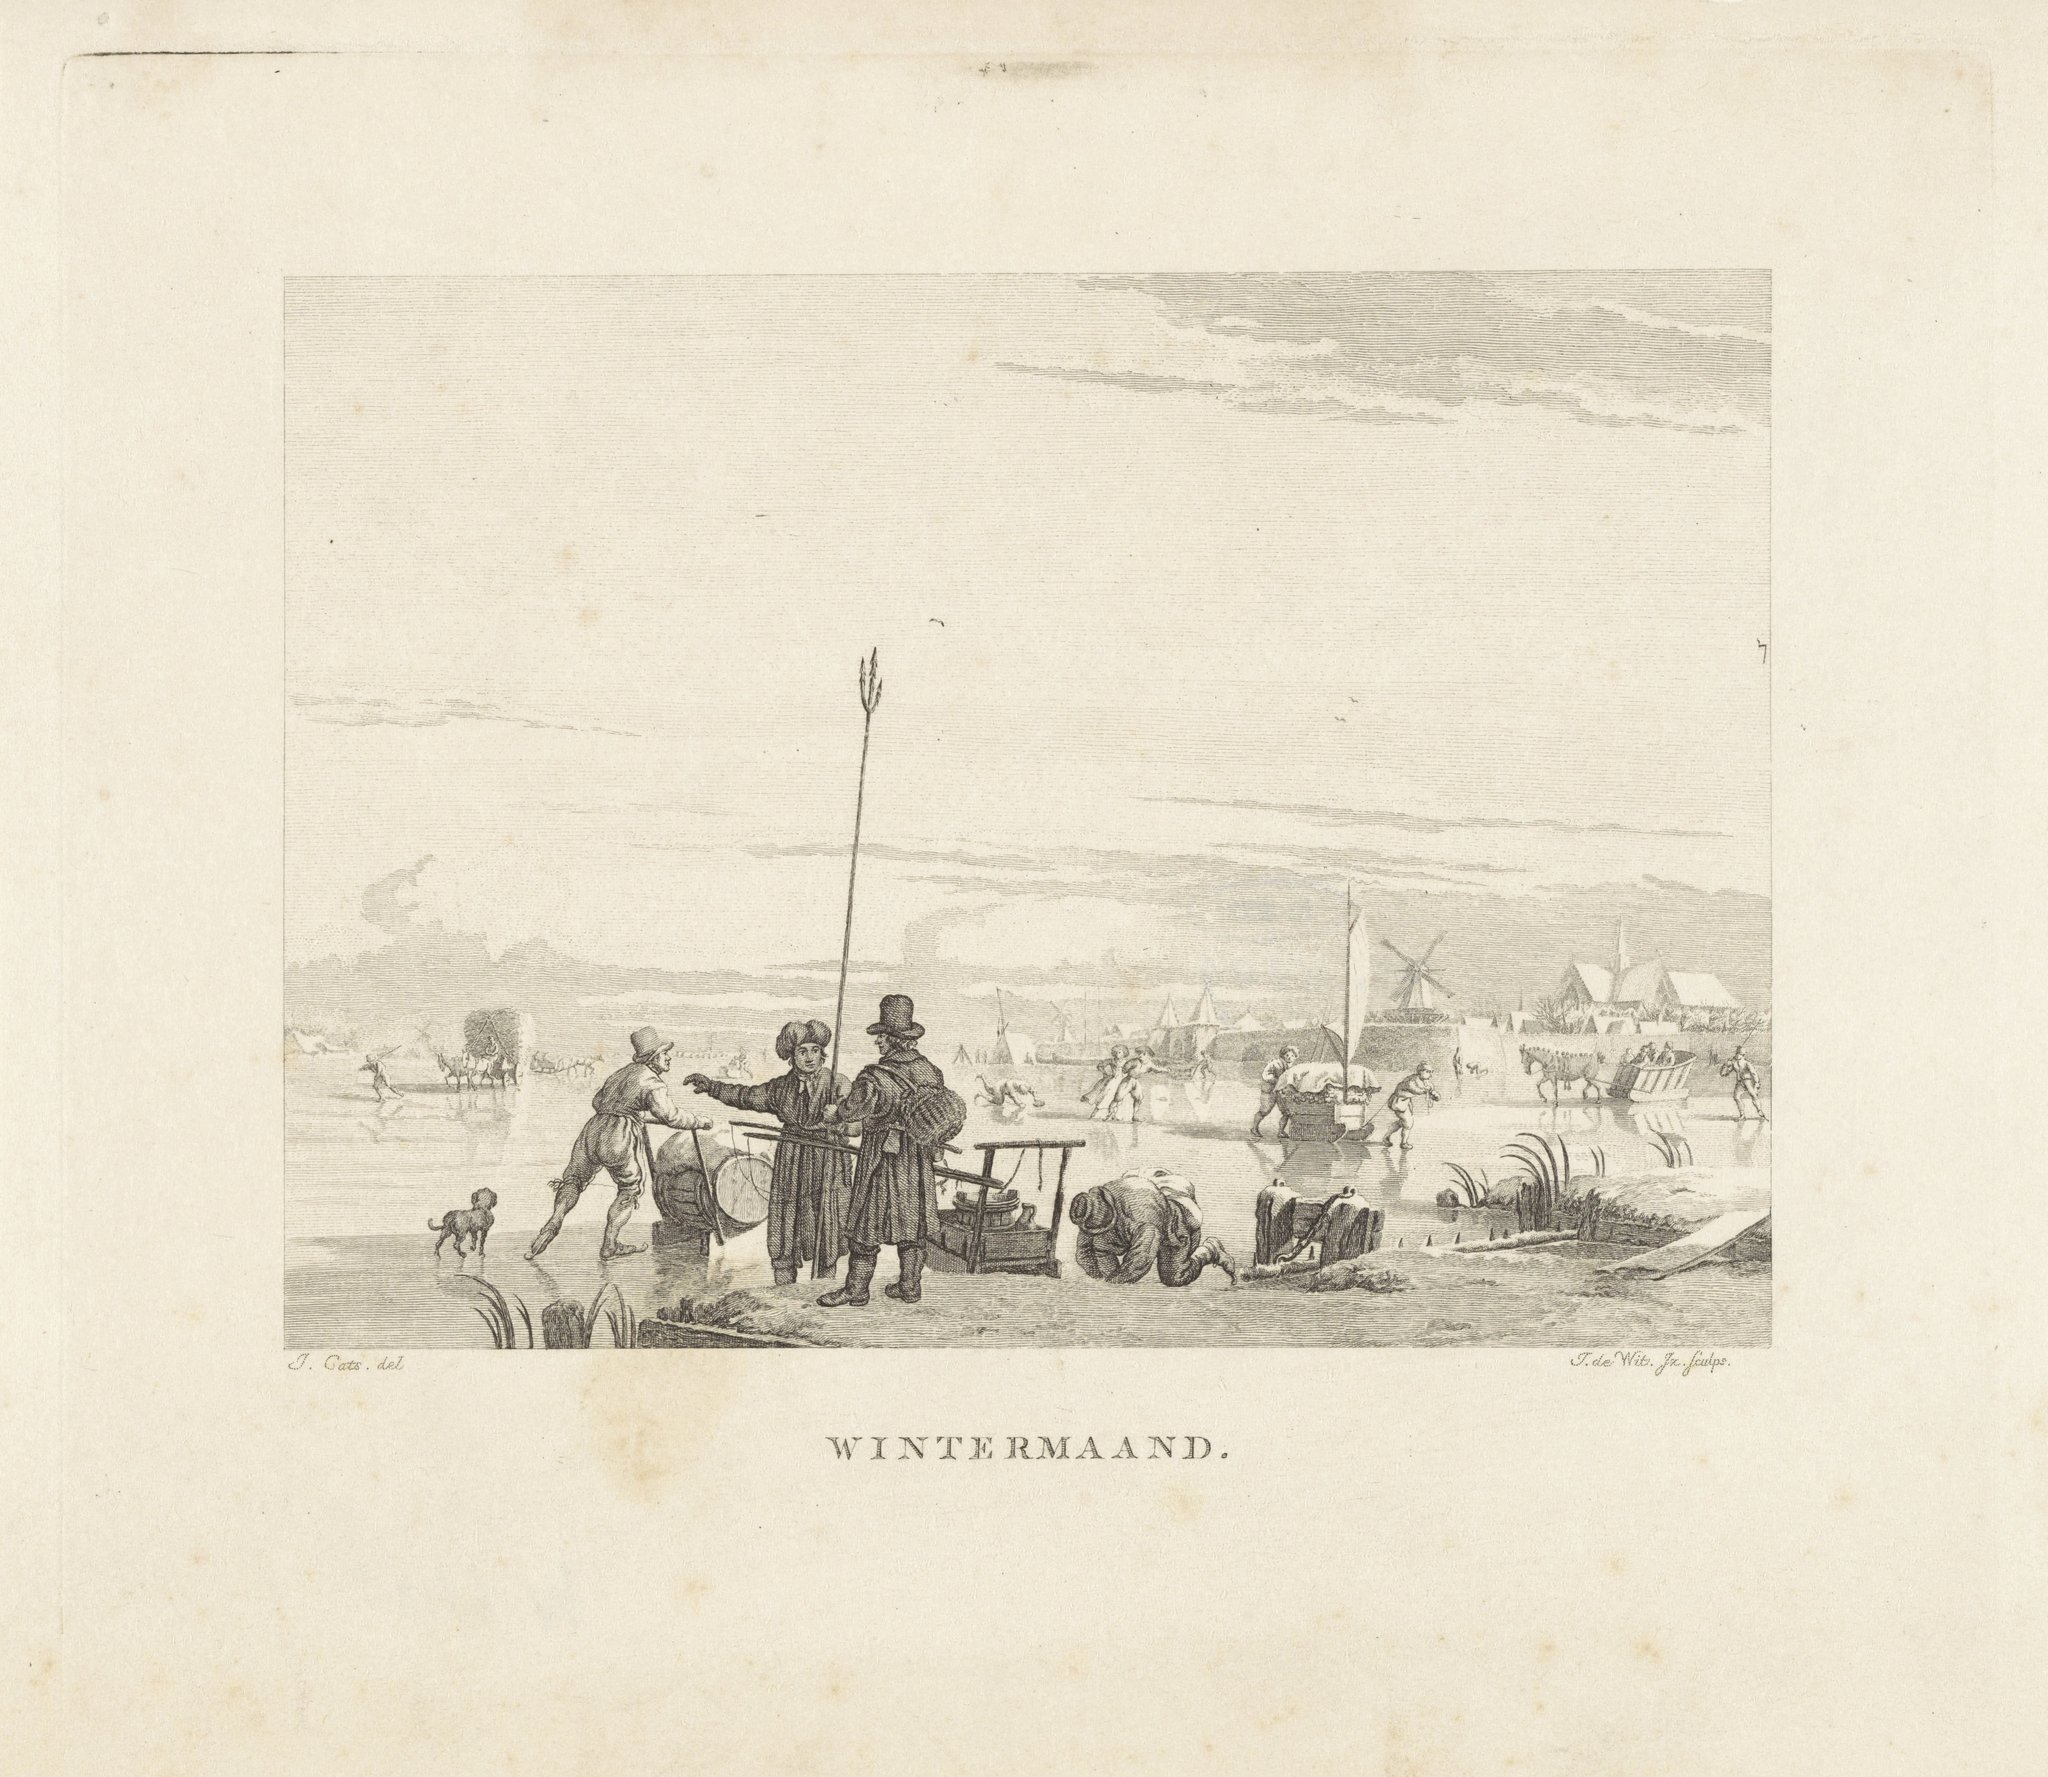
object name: print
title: De twaalf maanden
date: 1807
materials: paper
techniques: etching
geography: haarlem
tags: december and its 'labours' (+ with scenes showing human occupations ~ seasons and months), skates (winter sports), city-walls, sledge, sleigh (winter sports), windmill, parts of church exterior and annexes: tower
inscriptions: collector's mark: Lugt 2228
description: Gezicht op bevroren water met schaatsers en sleden; rechtsachter een ommuurde stad, met een molen en een kerktoren.